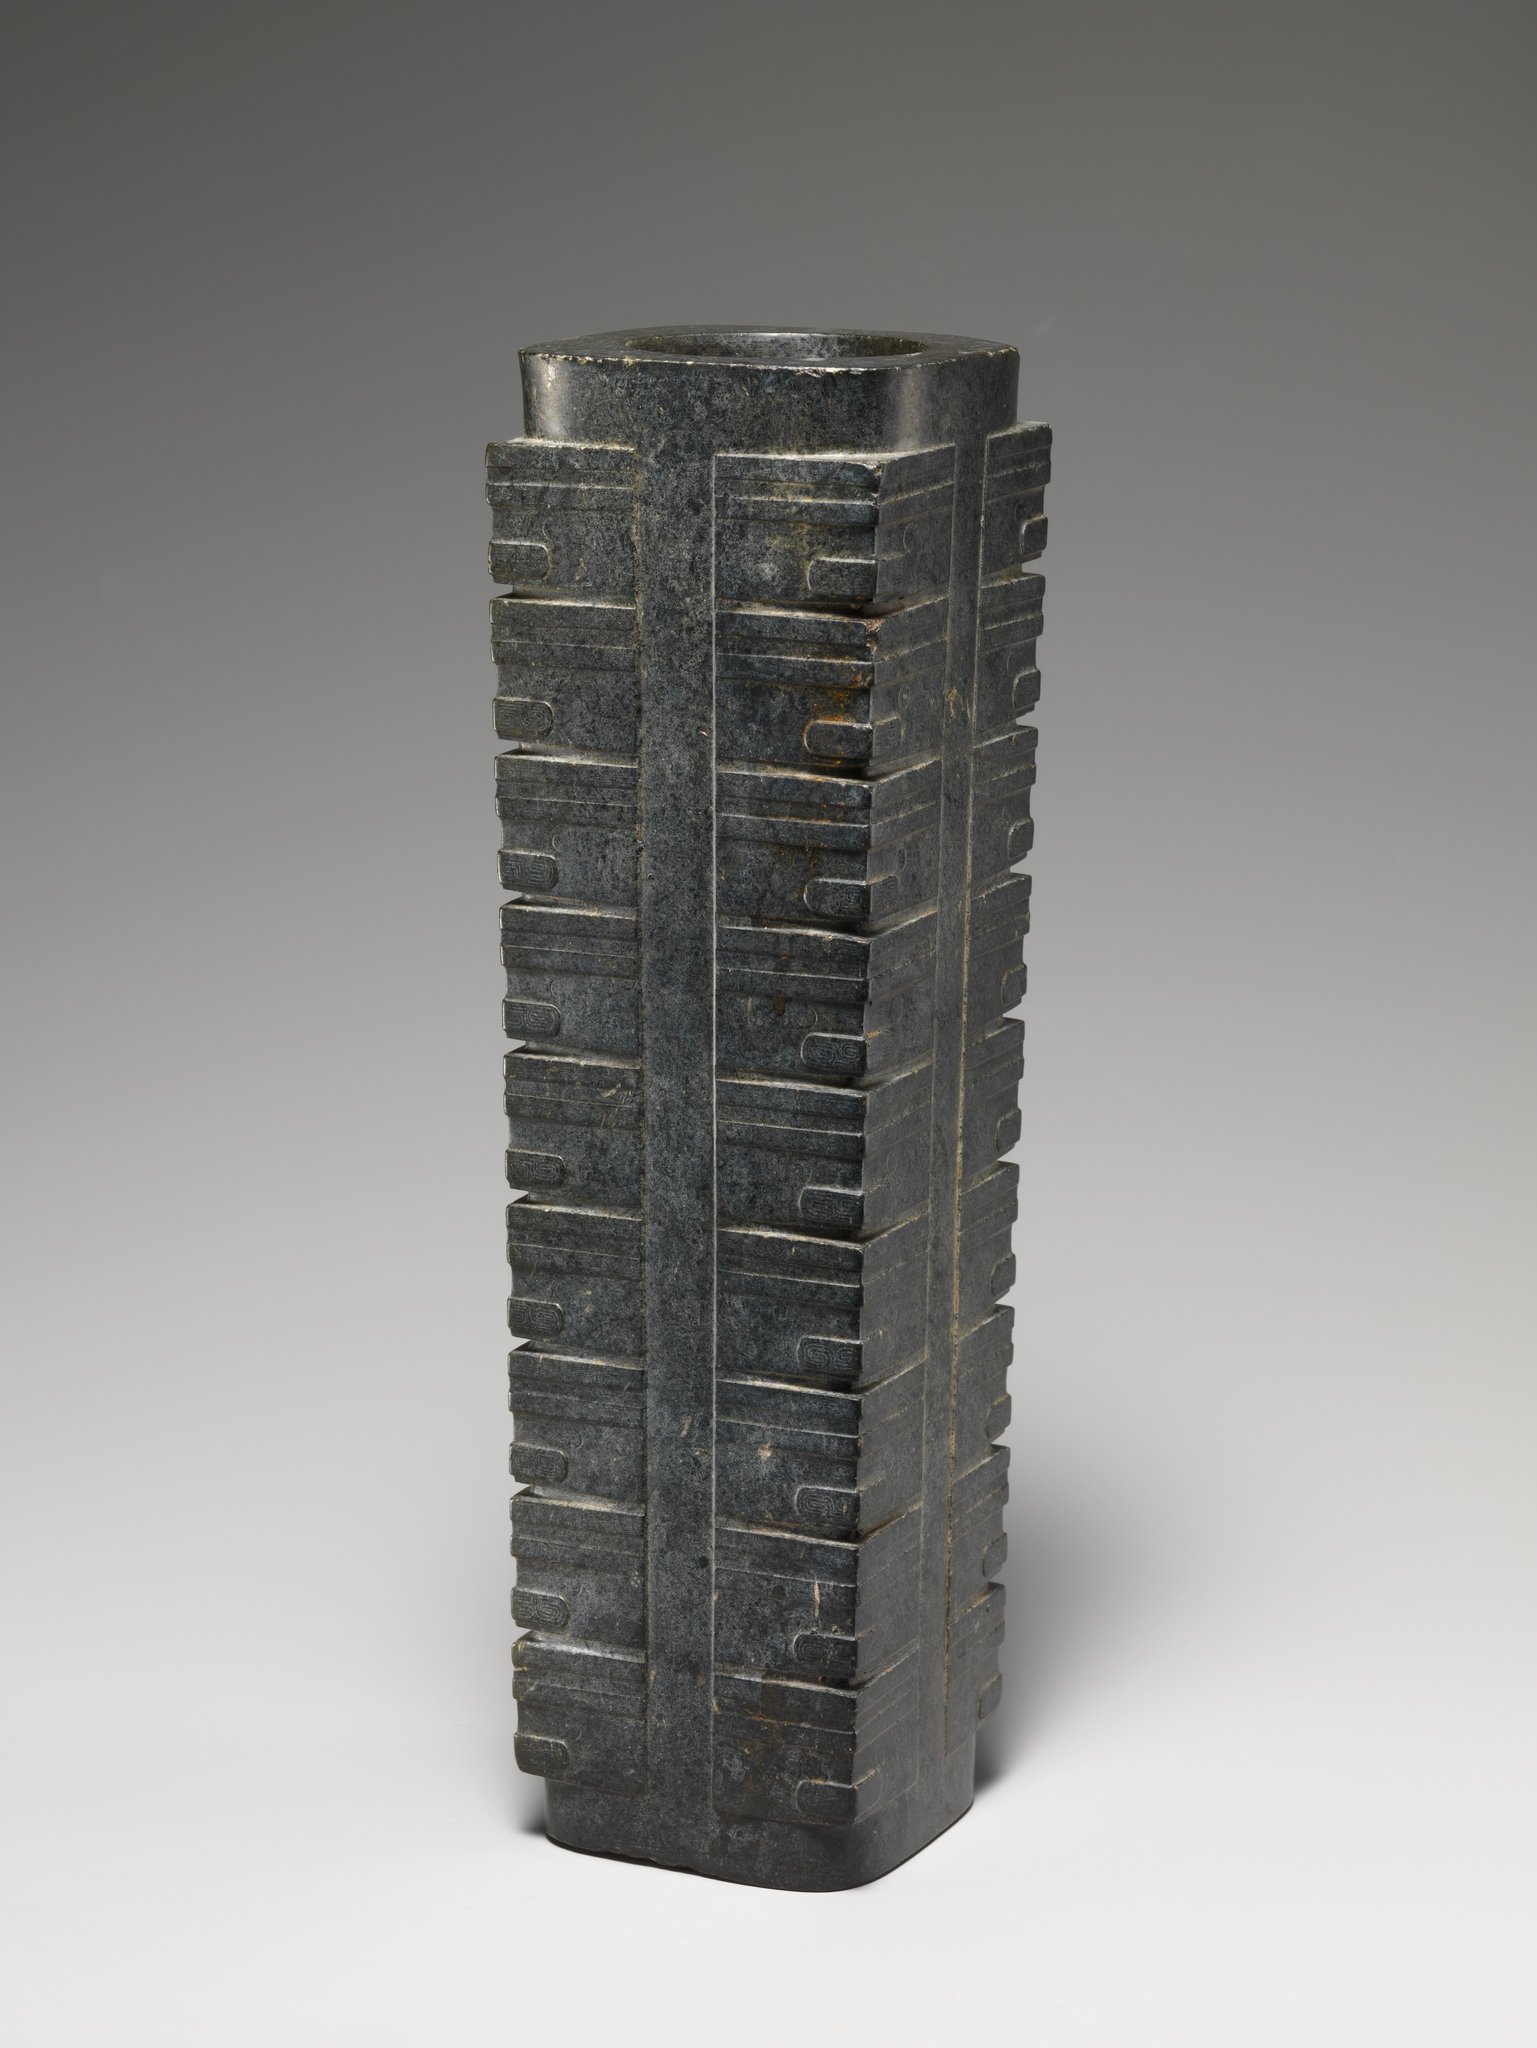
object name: religious ritual object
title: Ritual object (cong)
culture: chinese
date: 2400 BCE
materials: jade